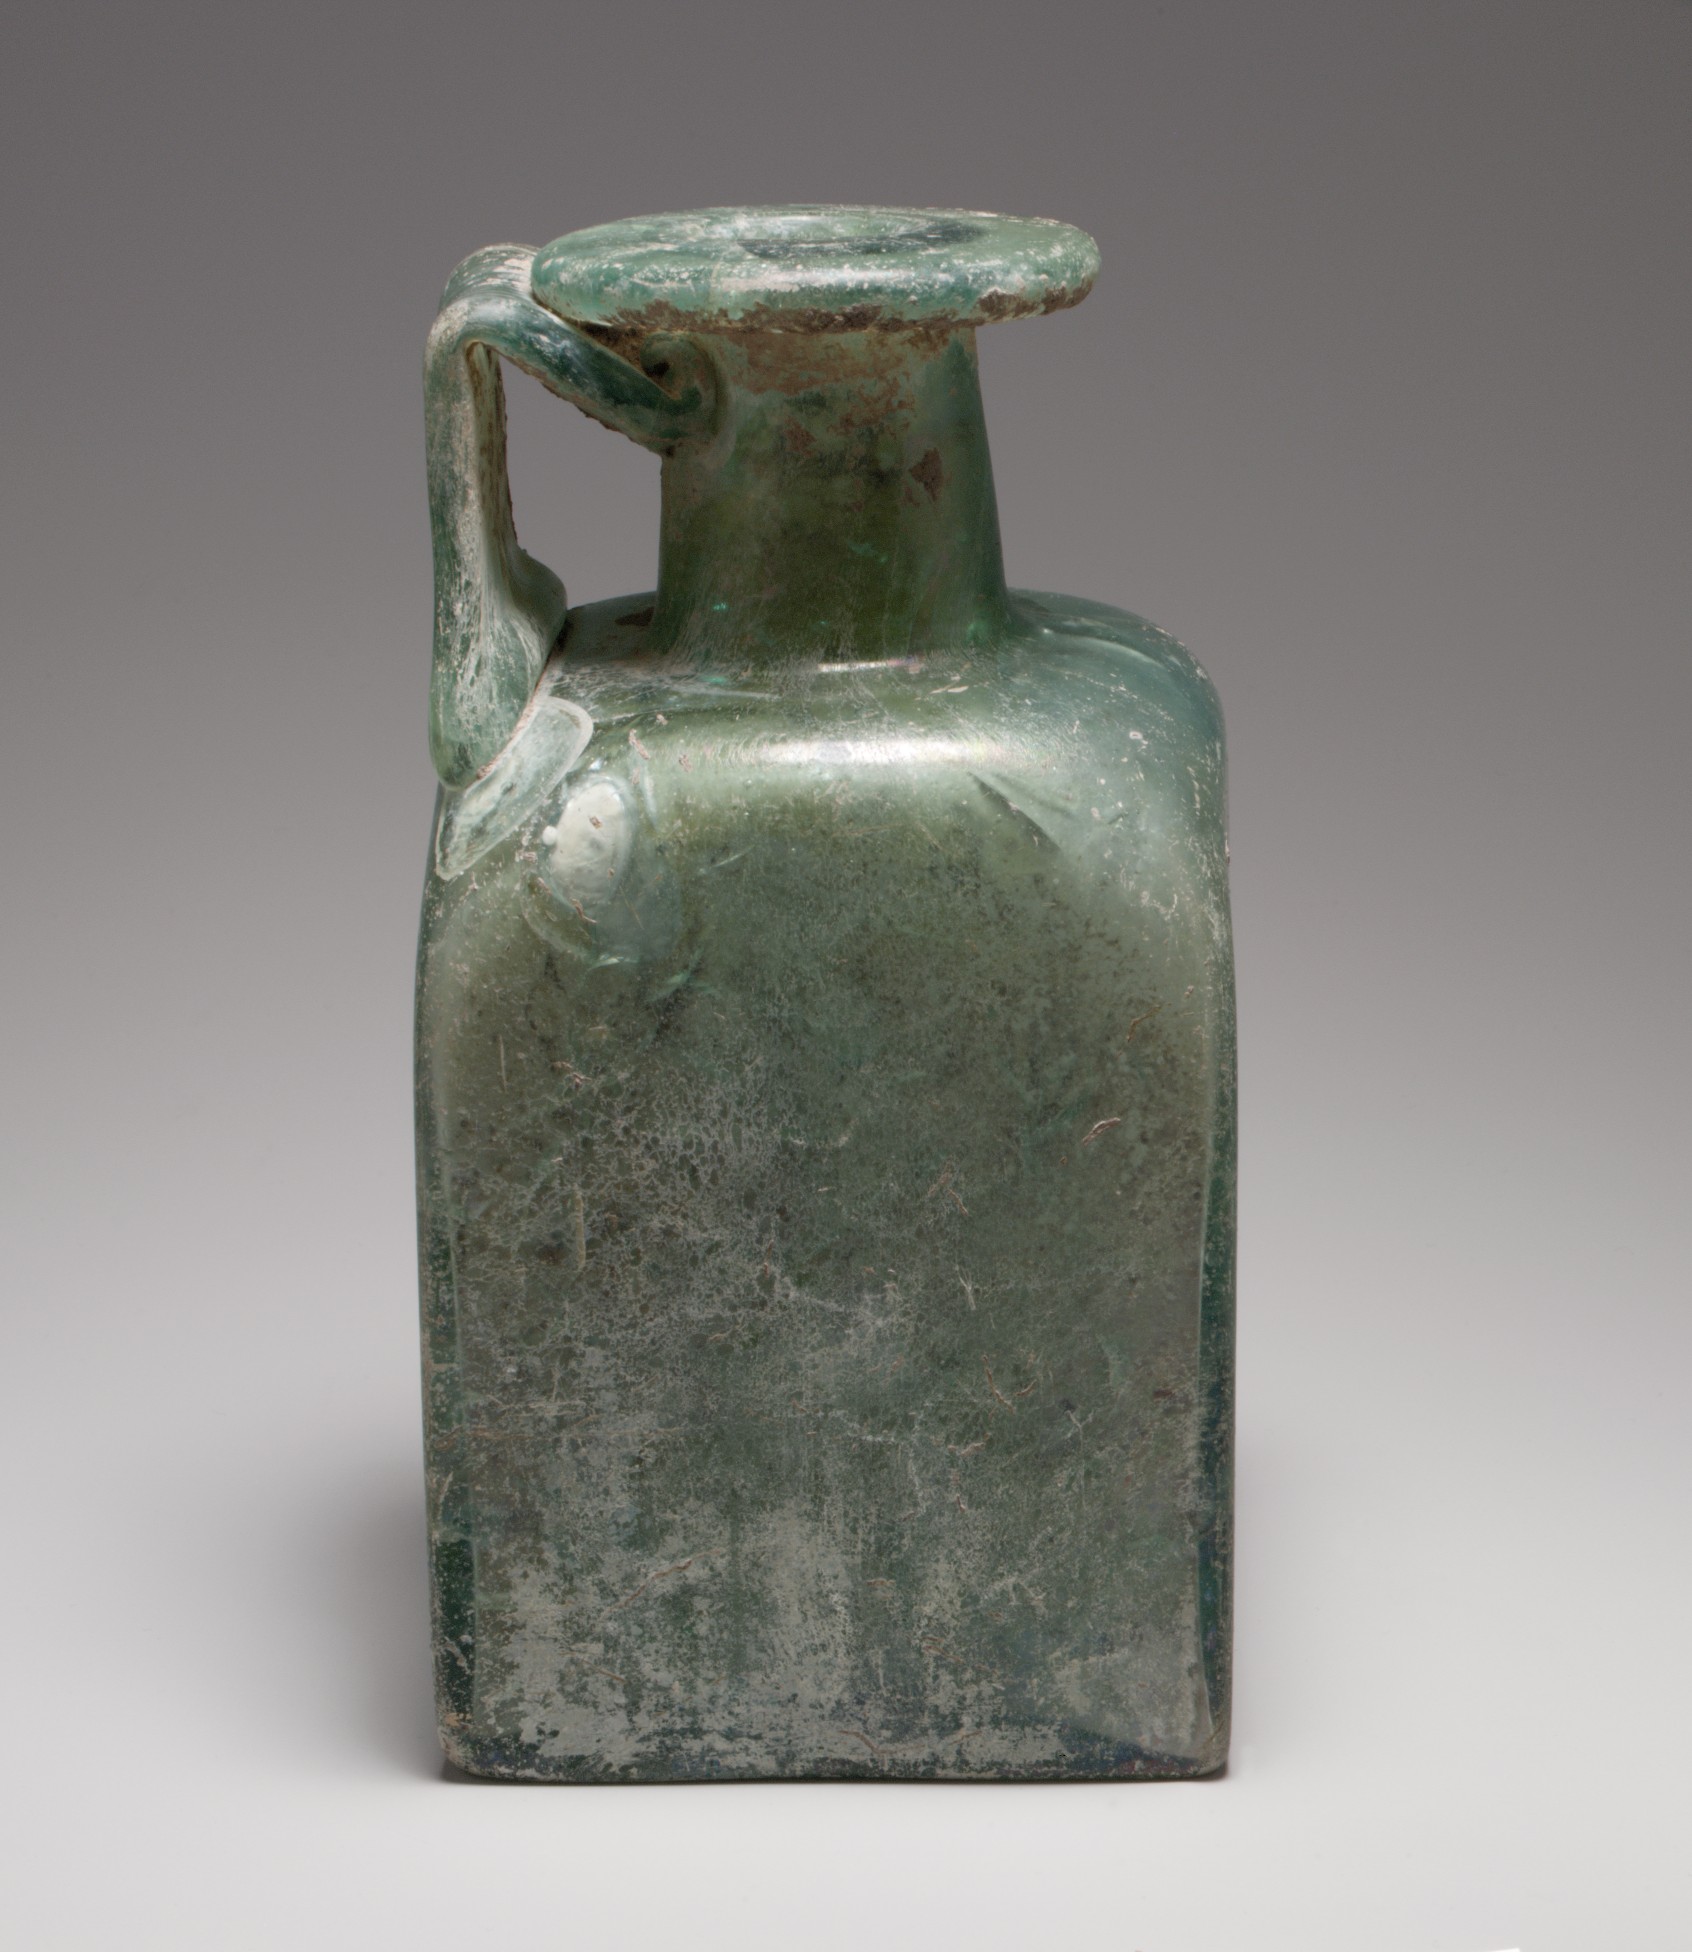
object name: bottle, square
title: Glass square bottle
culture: roman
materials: glass